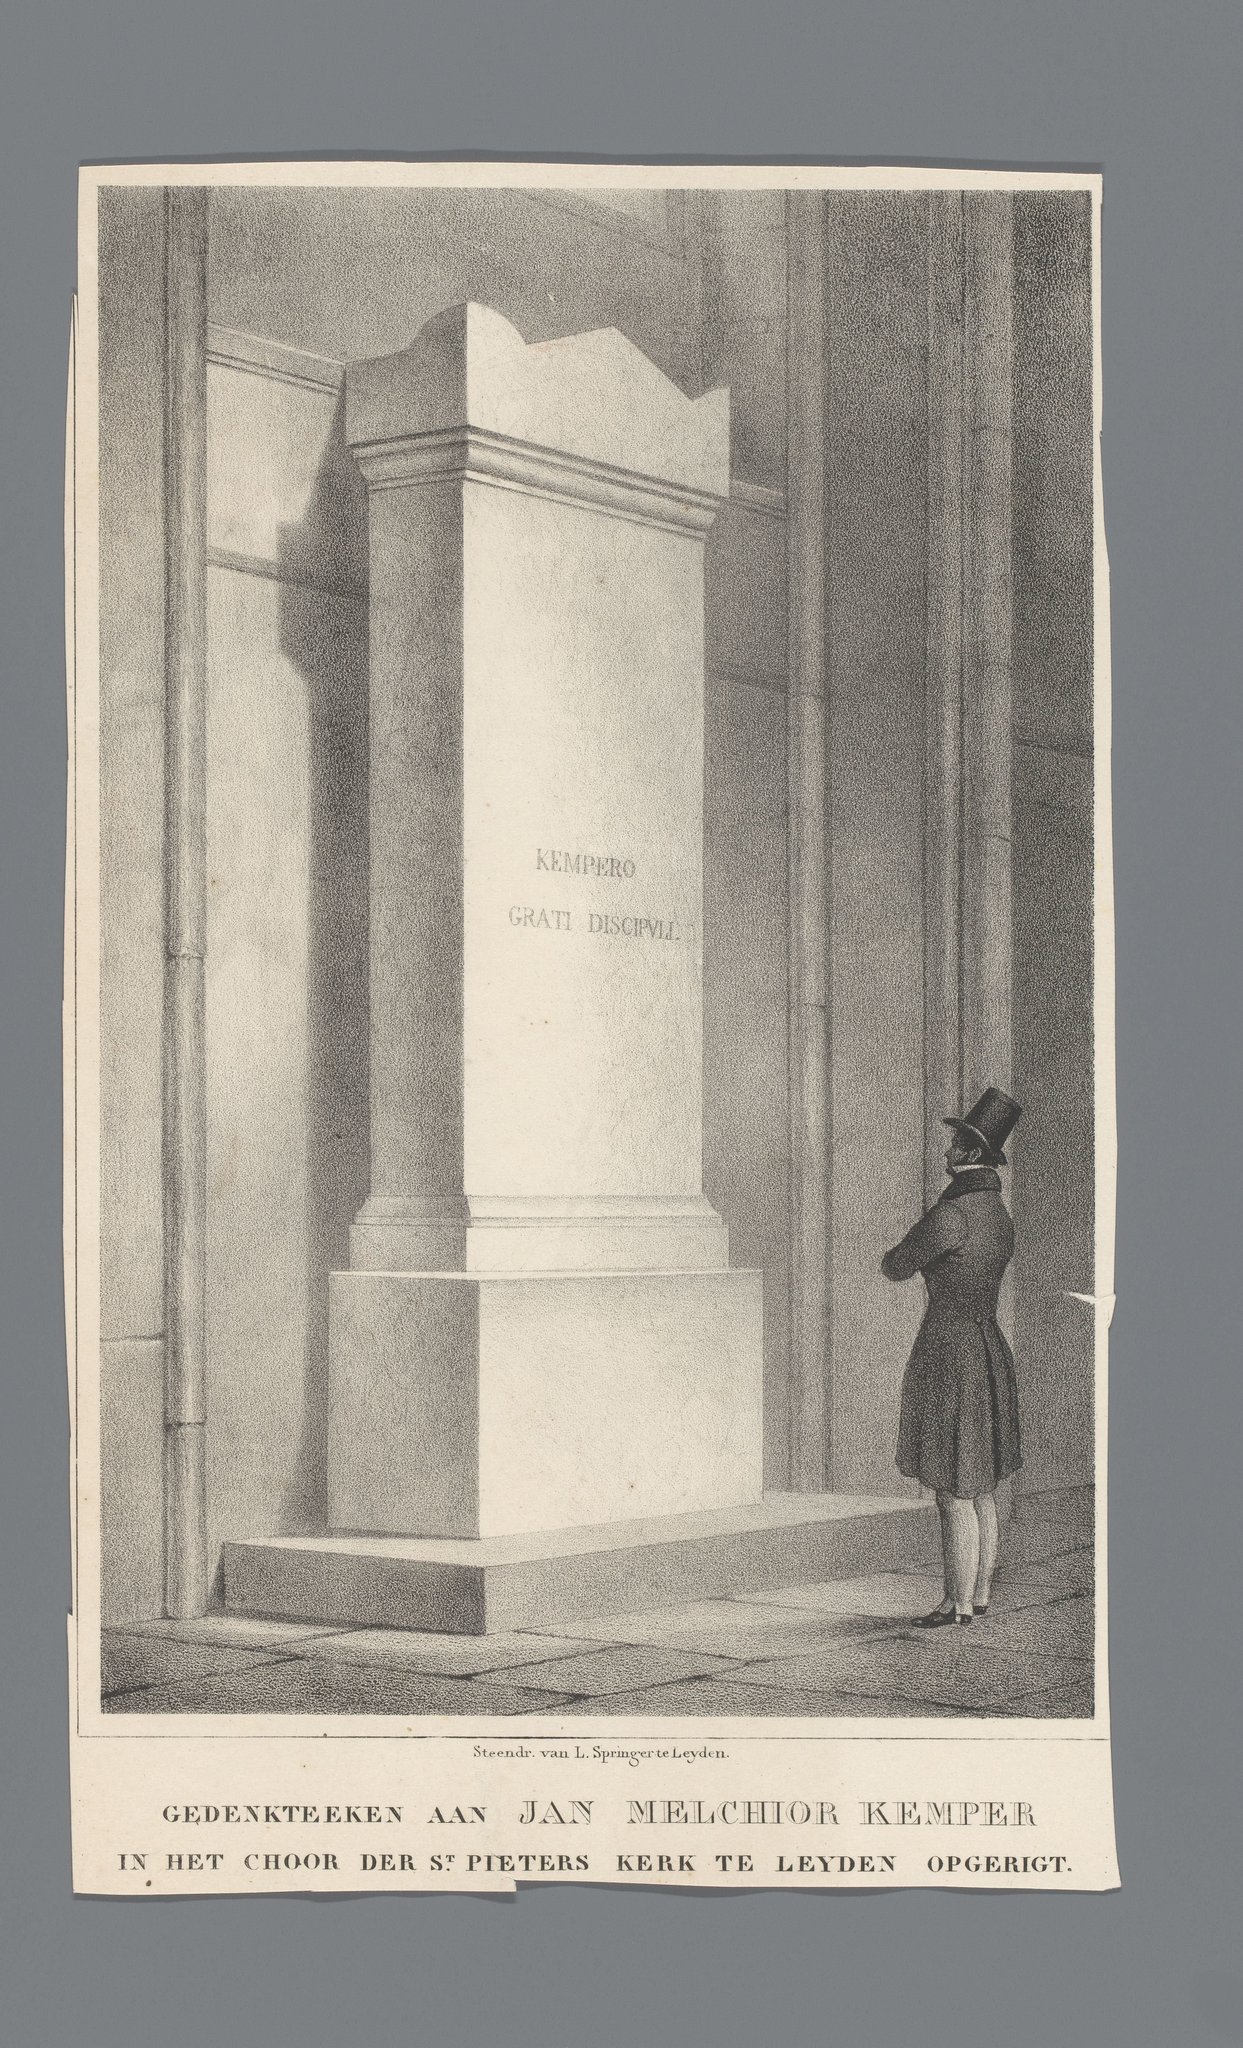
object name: print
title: Gedenkteken voor J.M. Kemper in de Pieterskerk te Leiden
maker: leendert springer (i)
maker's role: draughtsman, painter, print maker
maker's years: 1789-1871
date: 1835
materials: paper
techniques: lithograph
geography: leiden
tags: amsterdam, leiden, jonkheer joan melchior kemper, grave-building, monumental tomb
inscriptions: collector's mark: Lugt 2228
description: Gedenkteken voor de Leidse professor Jan Melchior Kemper (overleden 20 juli 1824) opgericht in de Pieterskerk te Leiden op 30 mei 1835. Een man staande voor het sobere monument ontworpen door D. Humbert de Superville.